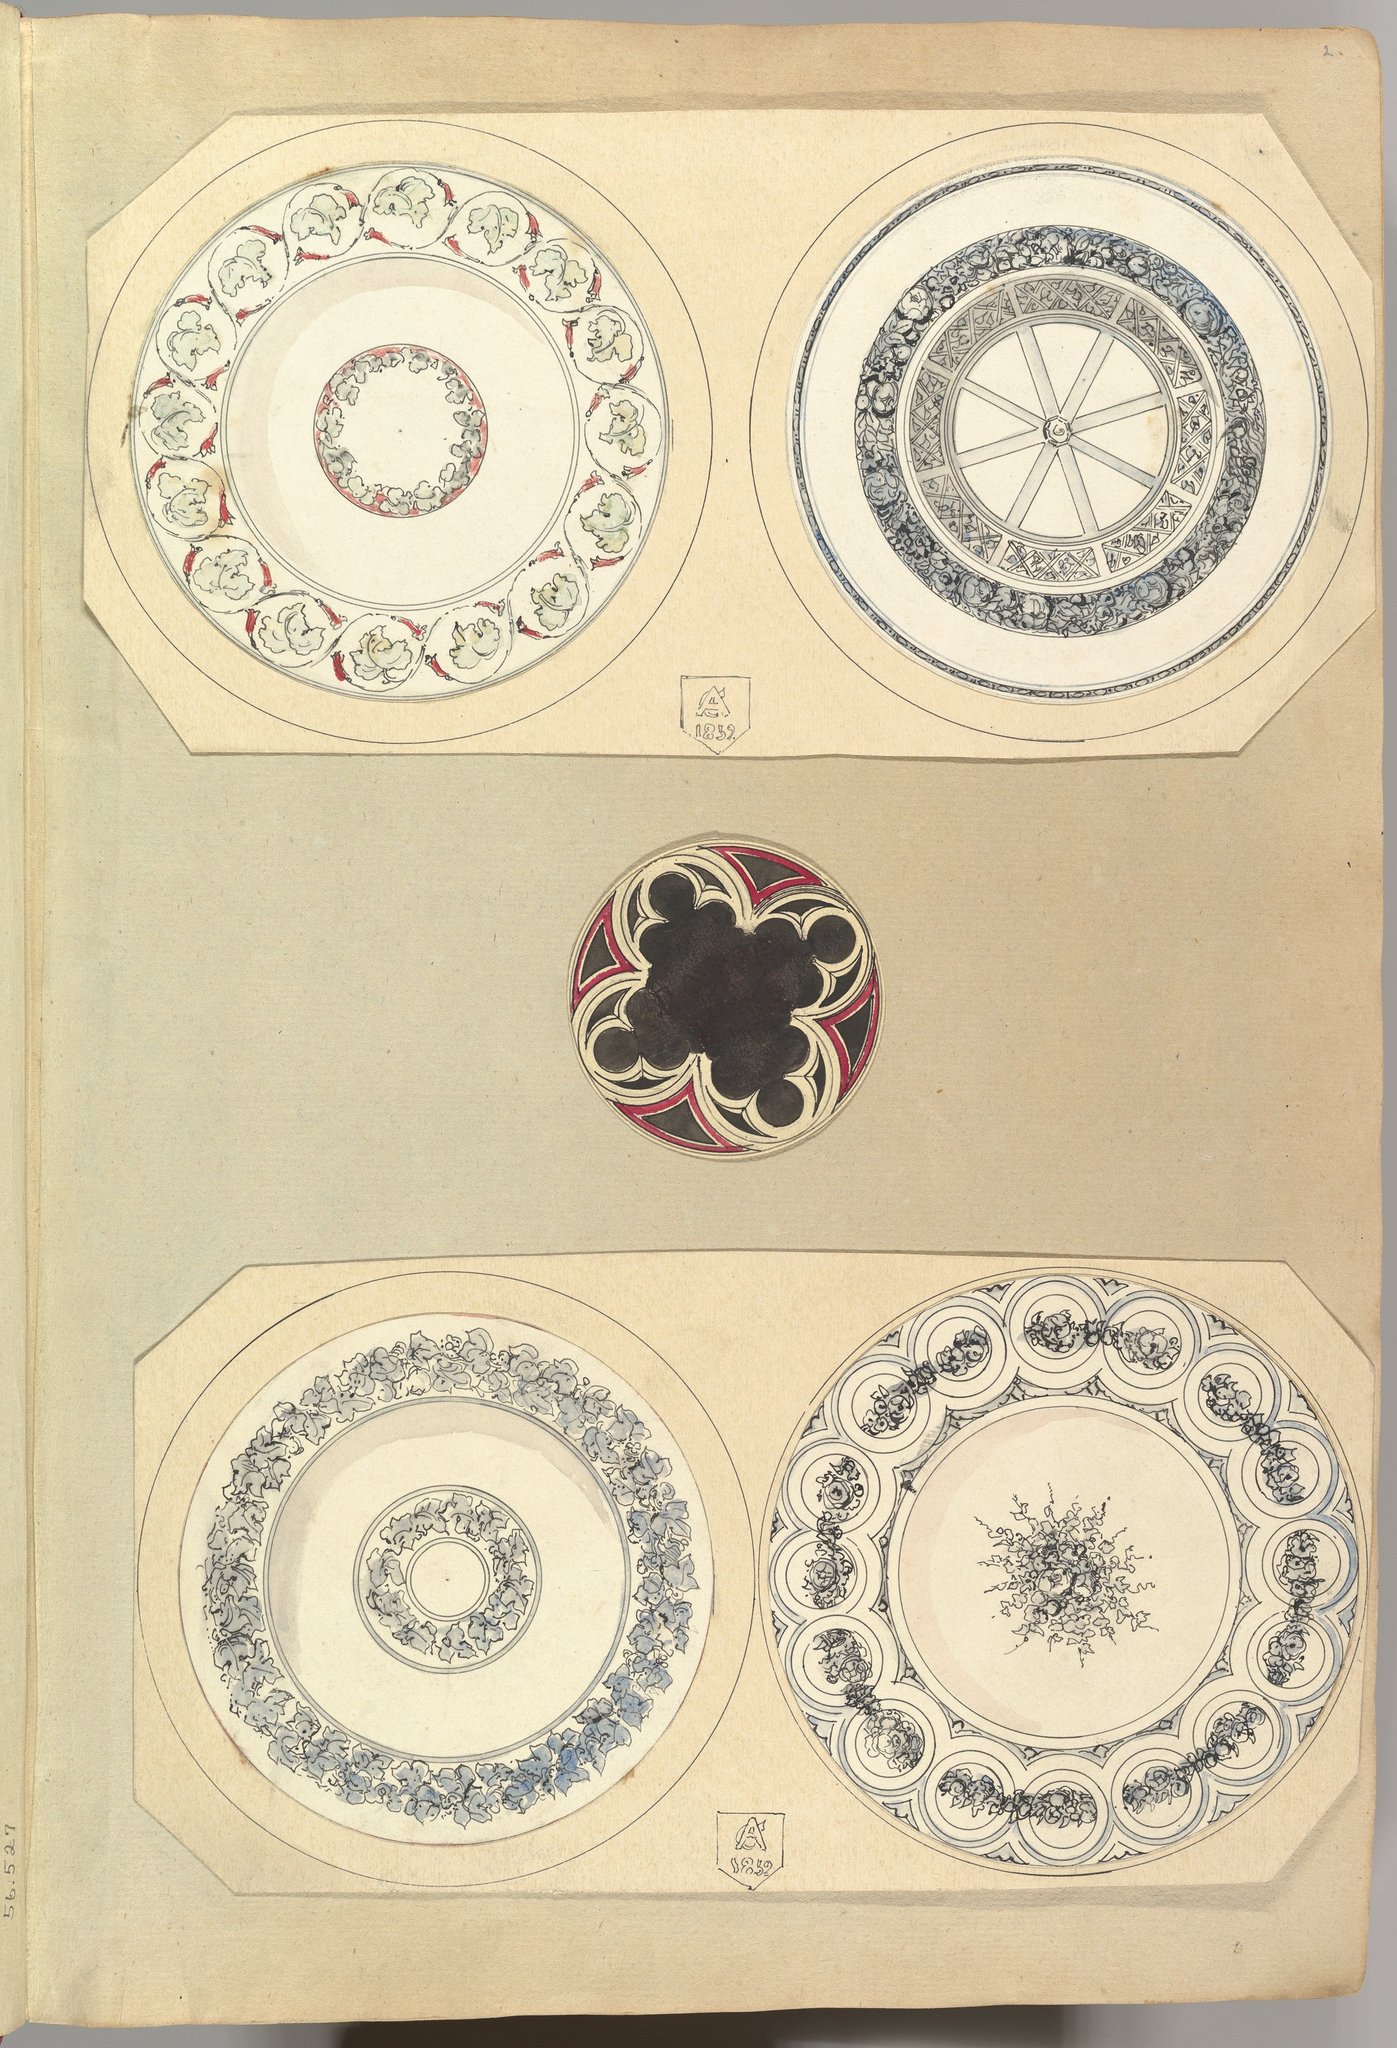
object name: drawing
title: Four Designs for Decorated Plates and a Quatrefoil Rondel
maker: alfred henry forrester [alfred crowquill]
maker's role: artist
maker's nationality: british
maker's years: 1804-1872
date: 1852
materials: gouache, ink, watercolor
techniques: pen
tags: dishes